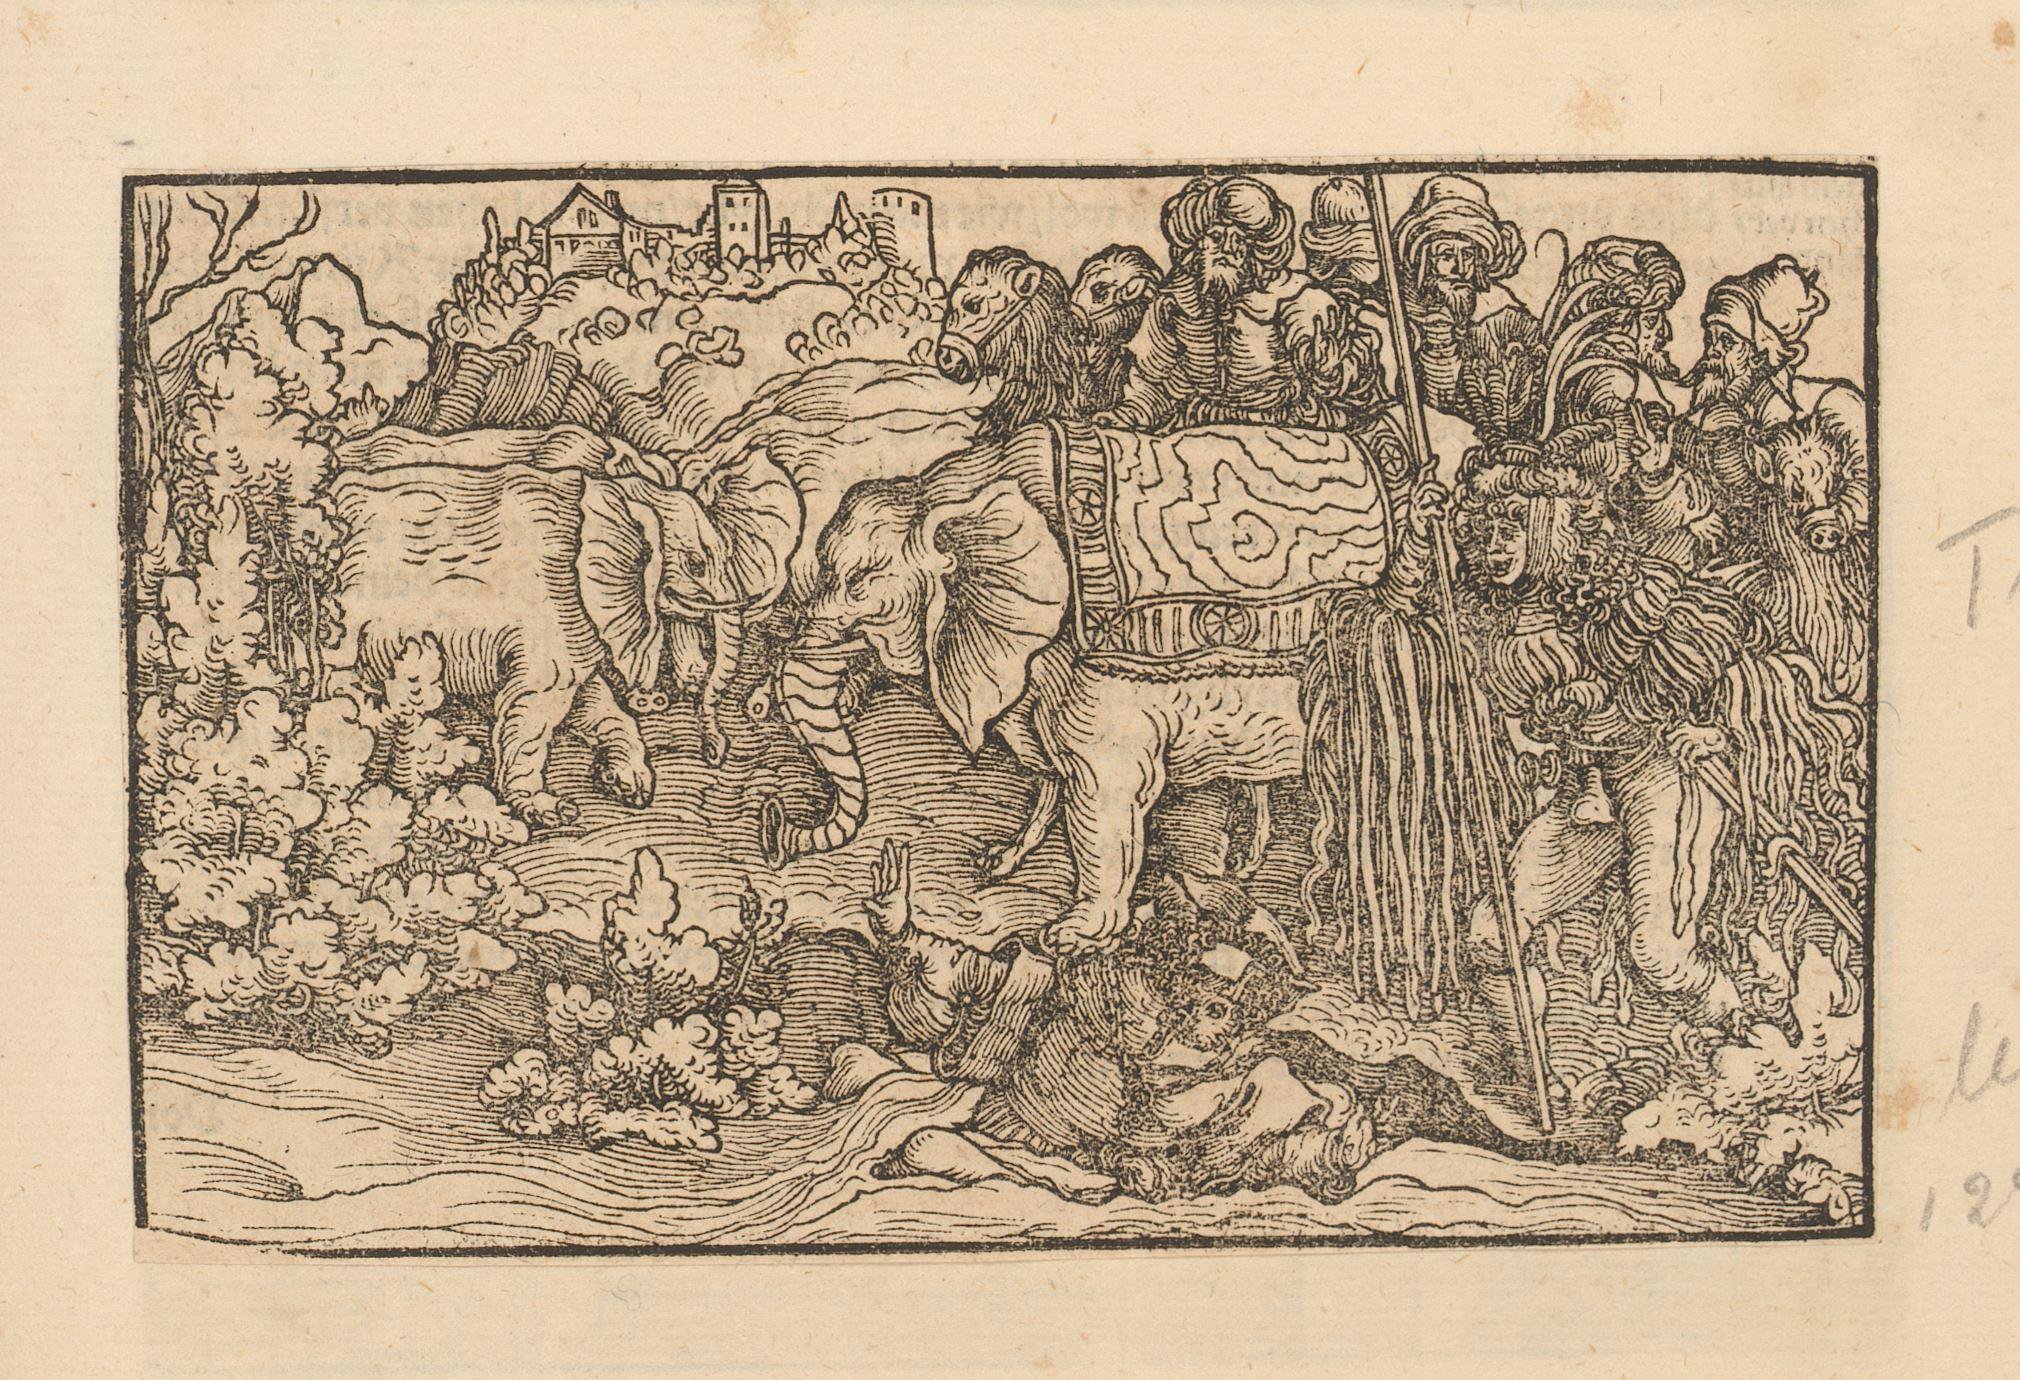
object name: print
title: Mannen op olifanten en kamelen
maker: Anonymous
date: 1514-1532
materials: paper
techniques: letterpress printing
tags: hannibal crosses the alps with his army and his elephants, trunked animals: elephant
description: Deze prent is gebruikt in: Petrarca, Francesco. Von der Artzney bayder Glück, des guten und widerwertigen: unnd weß sich ain yeder inn Gelück und Unglück halten sol (...). Augsburg: Heinrich Steiner, 1532. Deze uitgave is ook bekend onder de titel 'Trostspiegel in Glück und Unglück'.